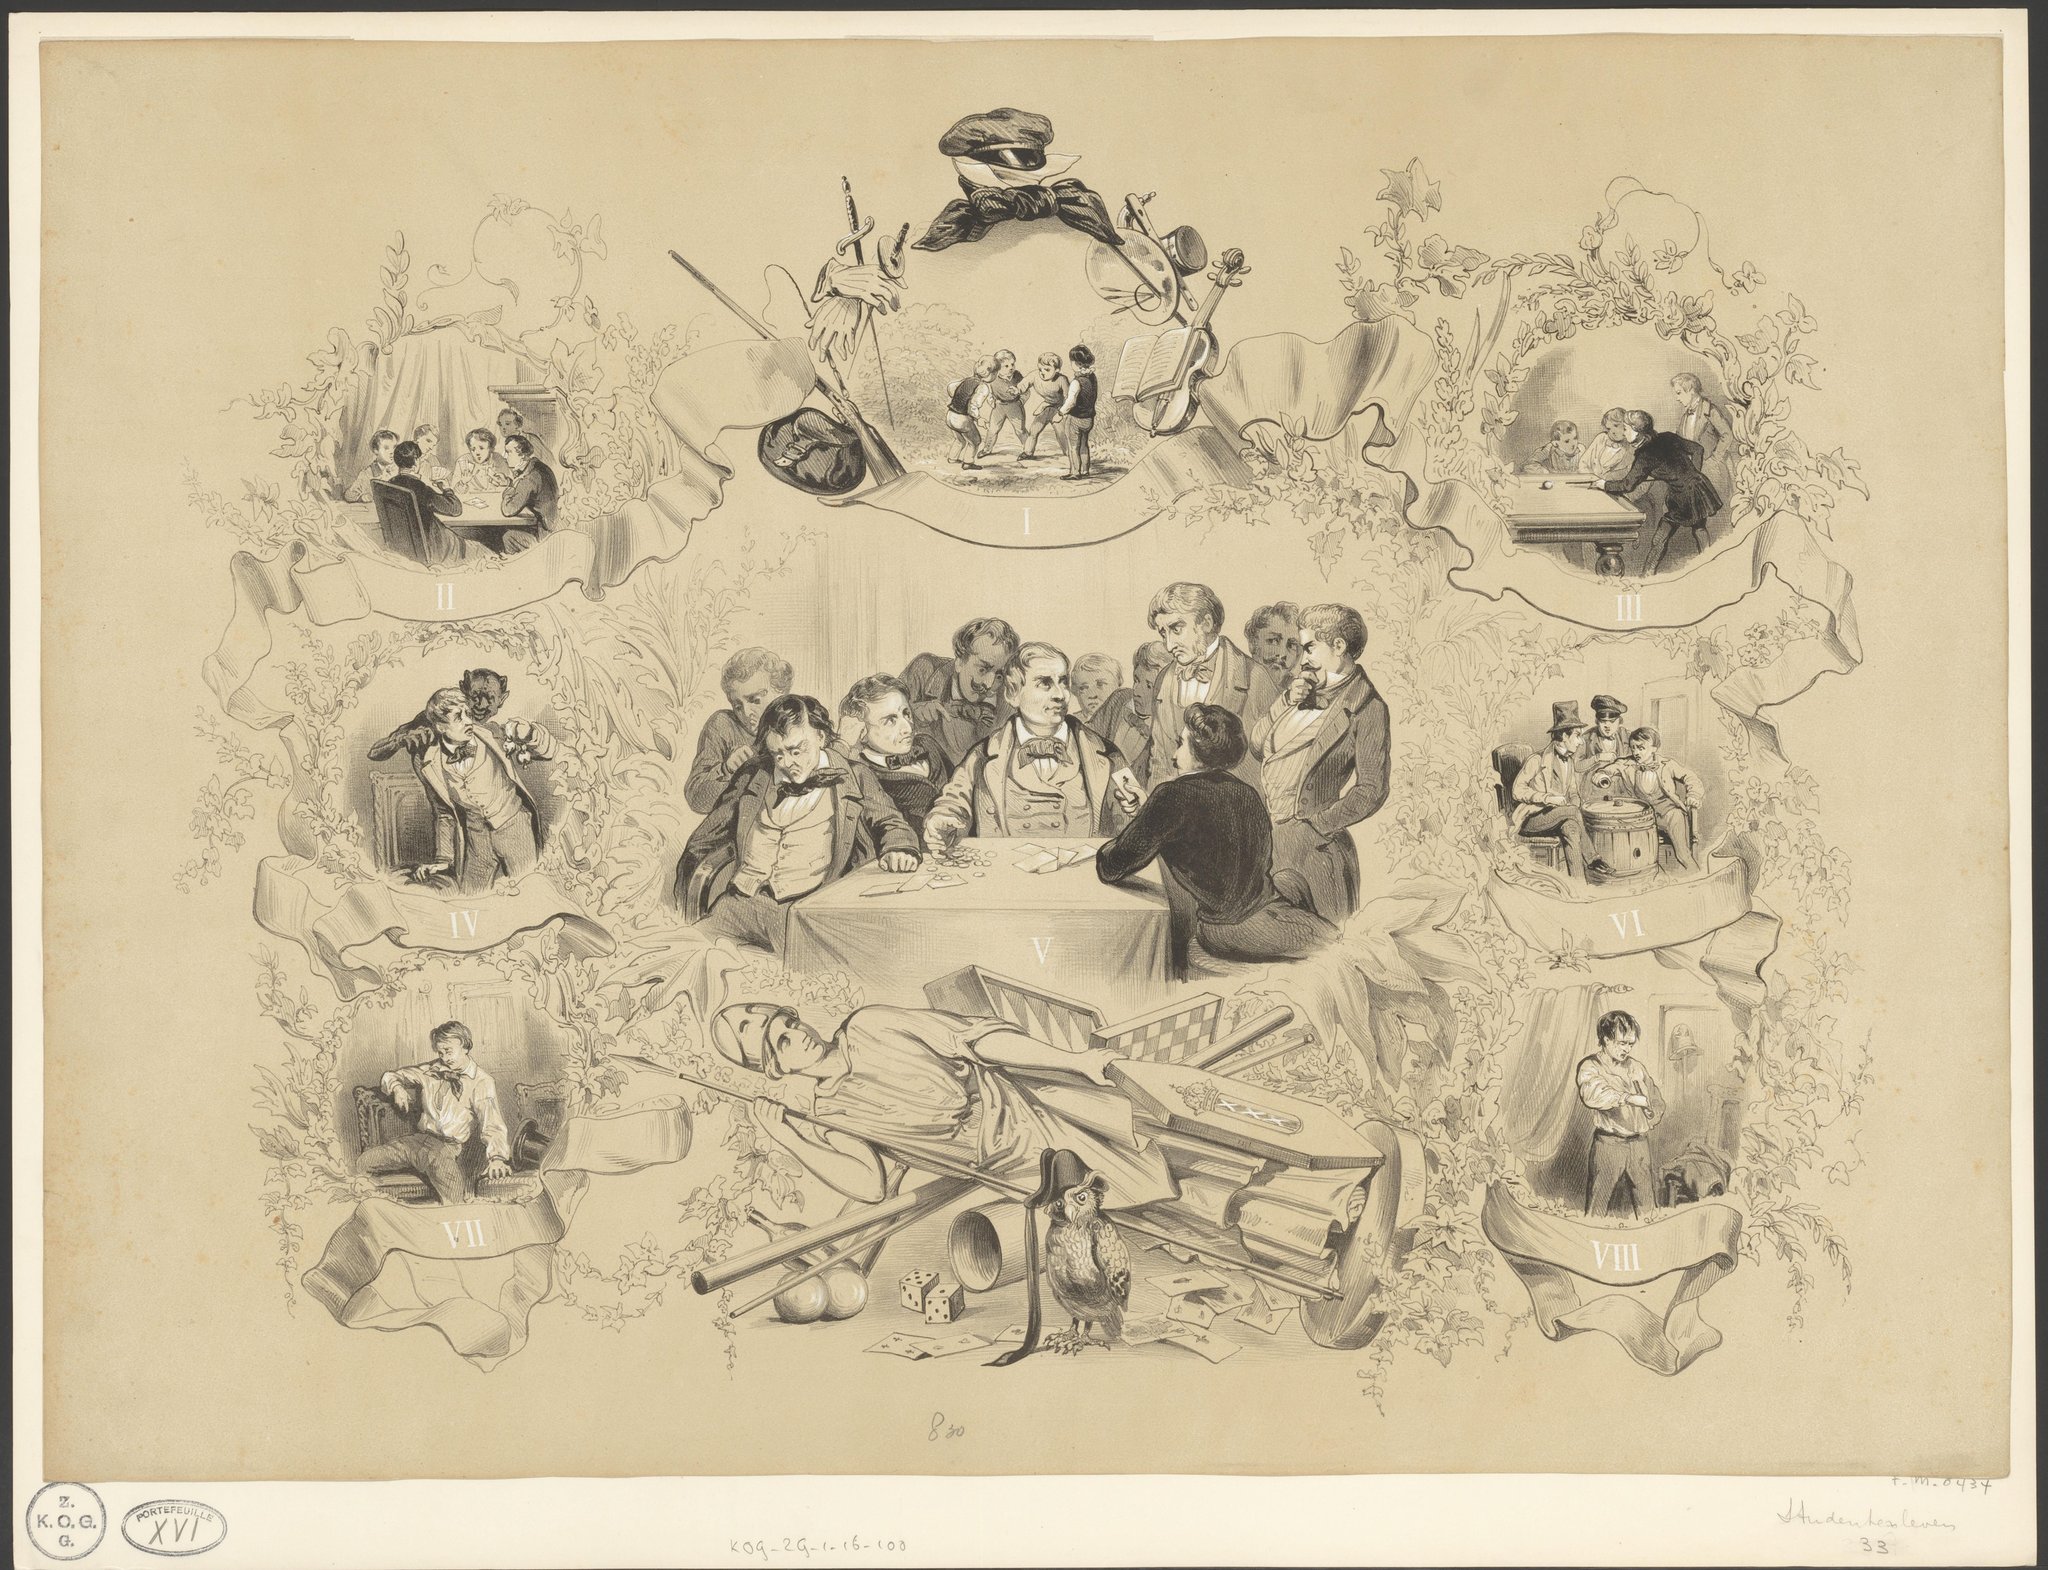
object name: cartoon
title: De demon van het spel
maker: Anonymous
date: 1855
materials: paper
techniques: lithograph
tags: fraternity (students), vocal music, singing, drinking, student life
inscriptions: stamp, collector's mark: Lugt 1641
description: Zinneprent met acht genummerde afbeeldingen. Een allegorie op het leven van een man die spellen speelt. Als kind knikkert hij in de buitenlucht, maar verliest zichzelf in spellen zoals dobbelen, biljart en kaartspelen op latere leeftijd. Uiteindelijk verliest hij al zijn geld en pleegt hij zelfmoord. Onderwerpsrubrieken binnen de Atlas Zeden en Gewoonten: Onderwijs en Wetenschappen, Studentenleven.